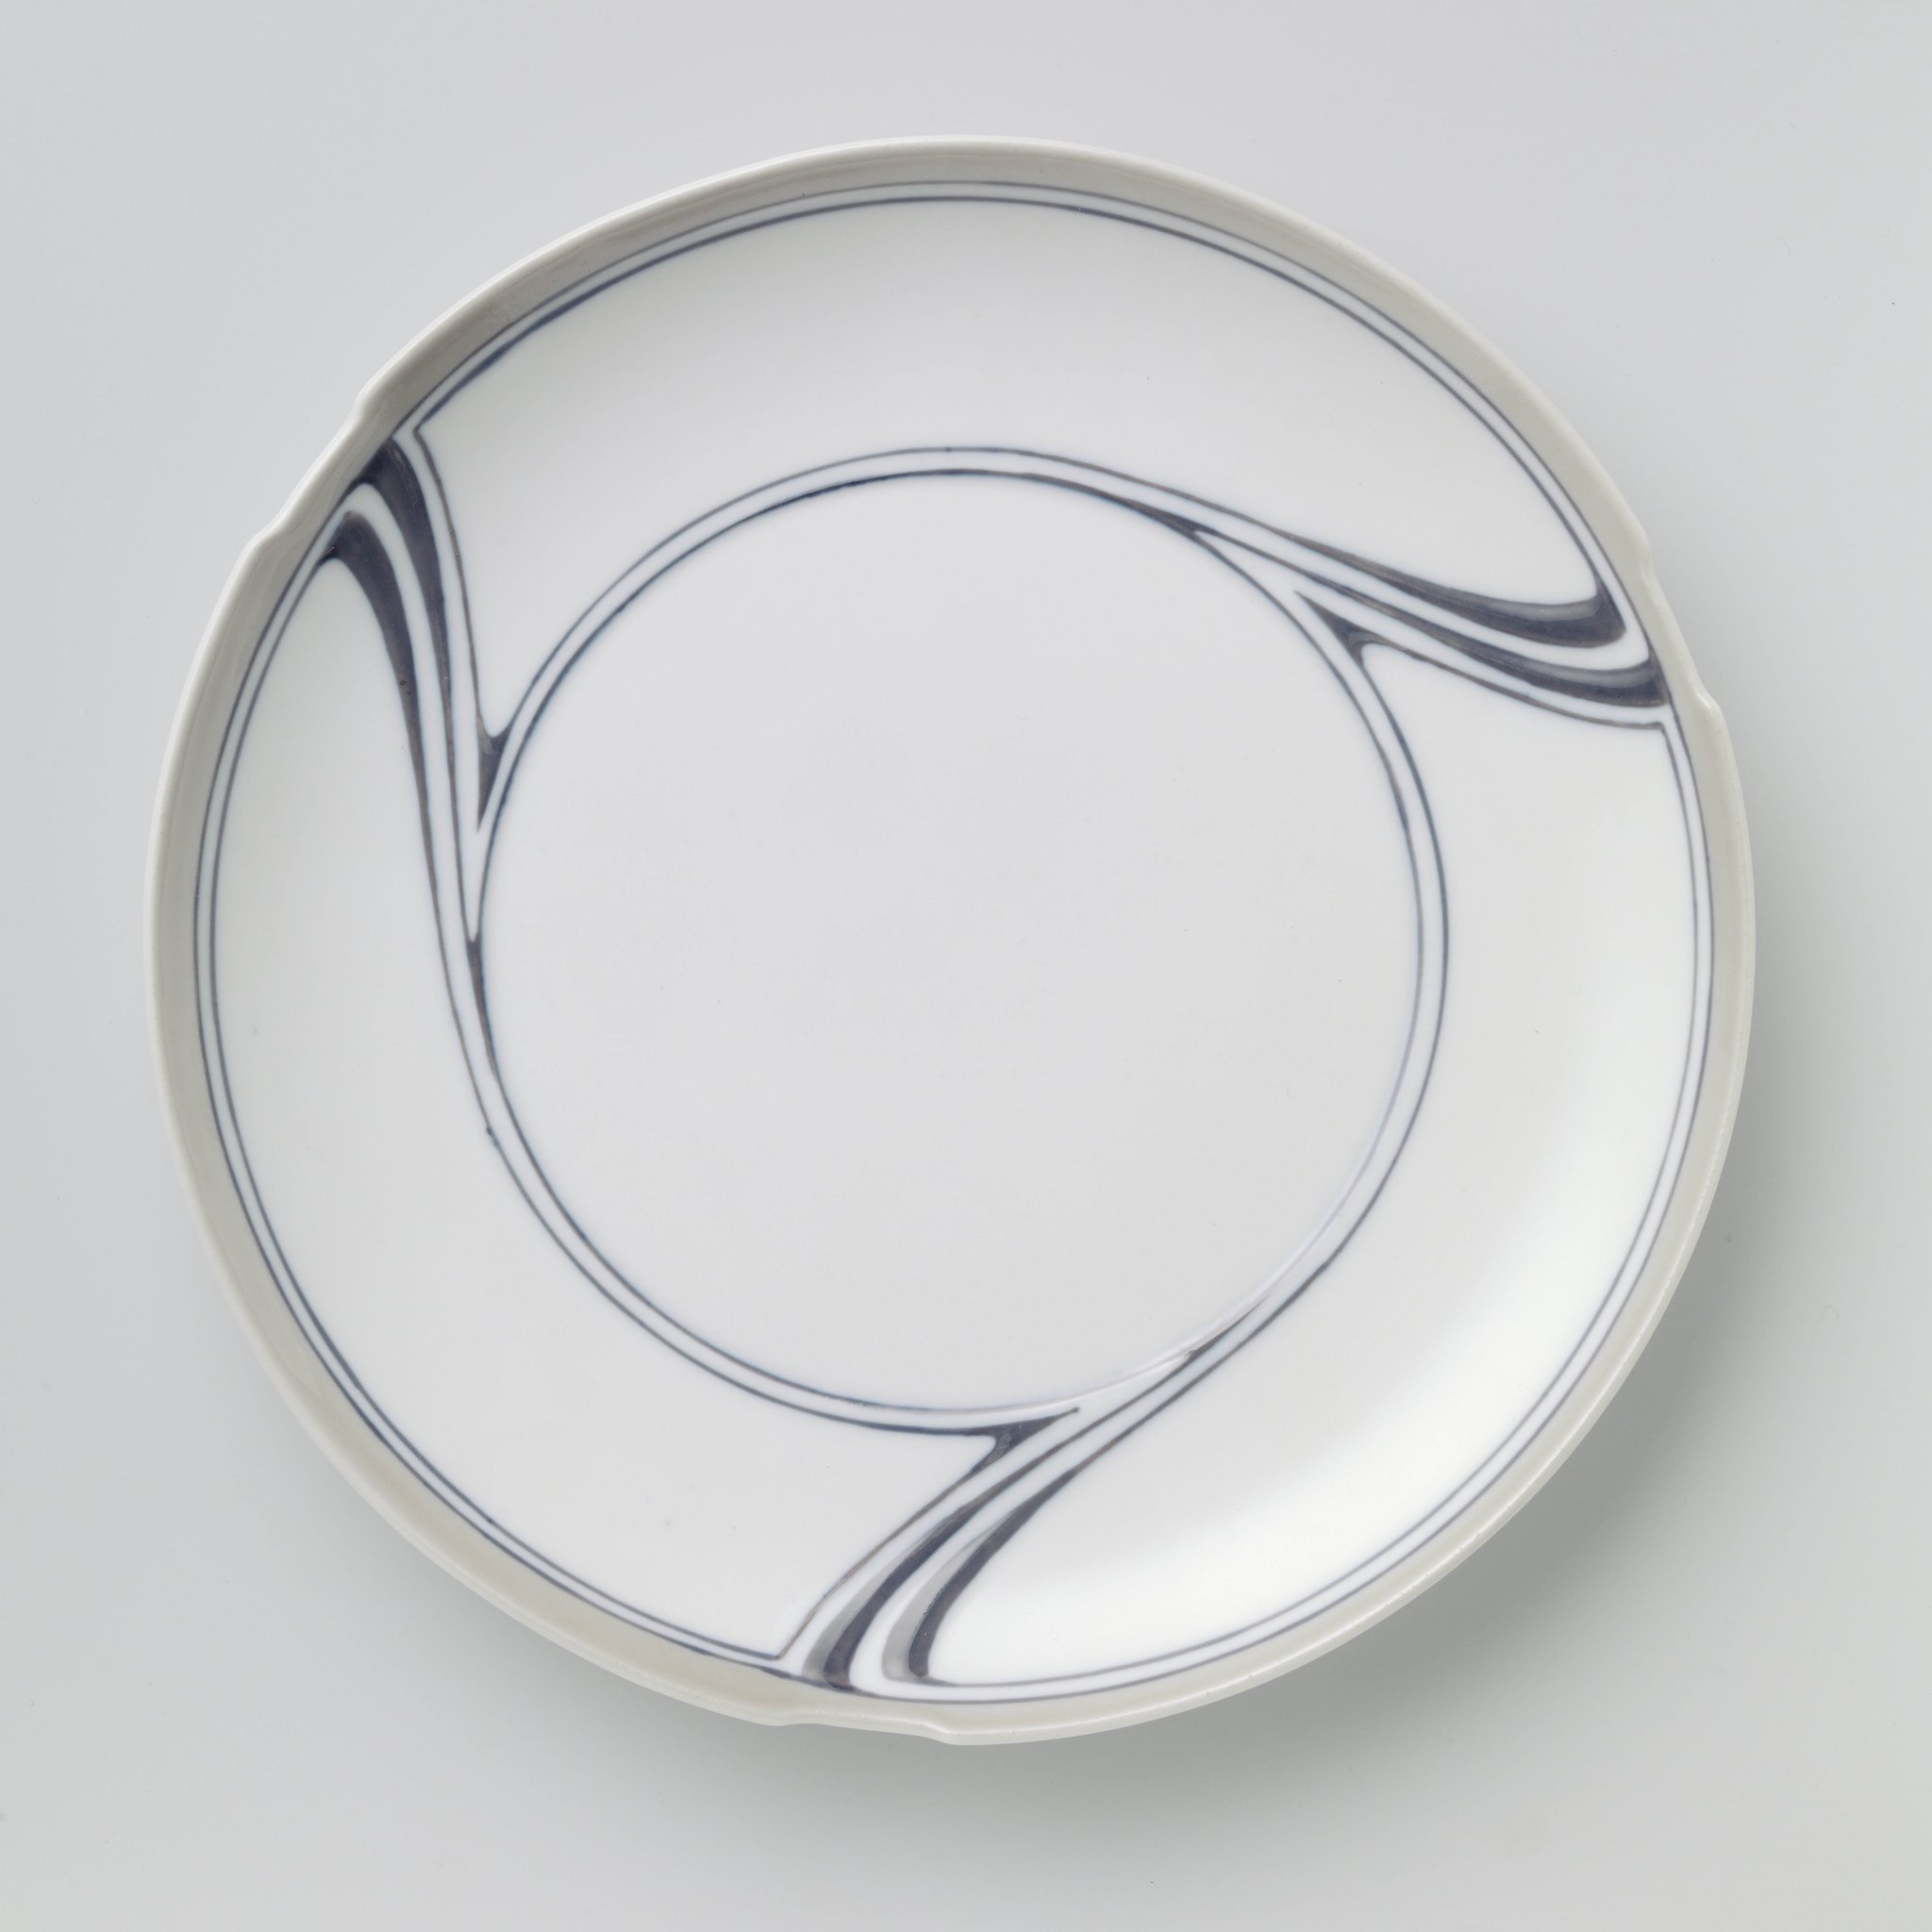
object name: eating drinking utensil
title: Bord uit het koffie- en theeservies 'Saxonia'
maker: otto eduard voigt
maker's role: keramiekontwerper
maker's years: 1870-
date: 1904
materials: porcelain, chemical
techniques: painted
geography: meissen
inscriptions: model number: ‘U 151’, factory mark, mark: ‘22 (of 69?)’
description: Bord van porselein, beschilderd in blauw en grijs. Het bord hoort bij het koffie- en theeservies Saxonia. Het bord is gemerkt.